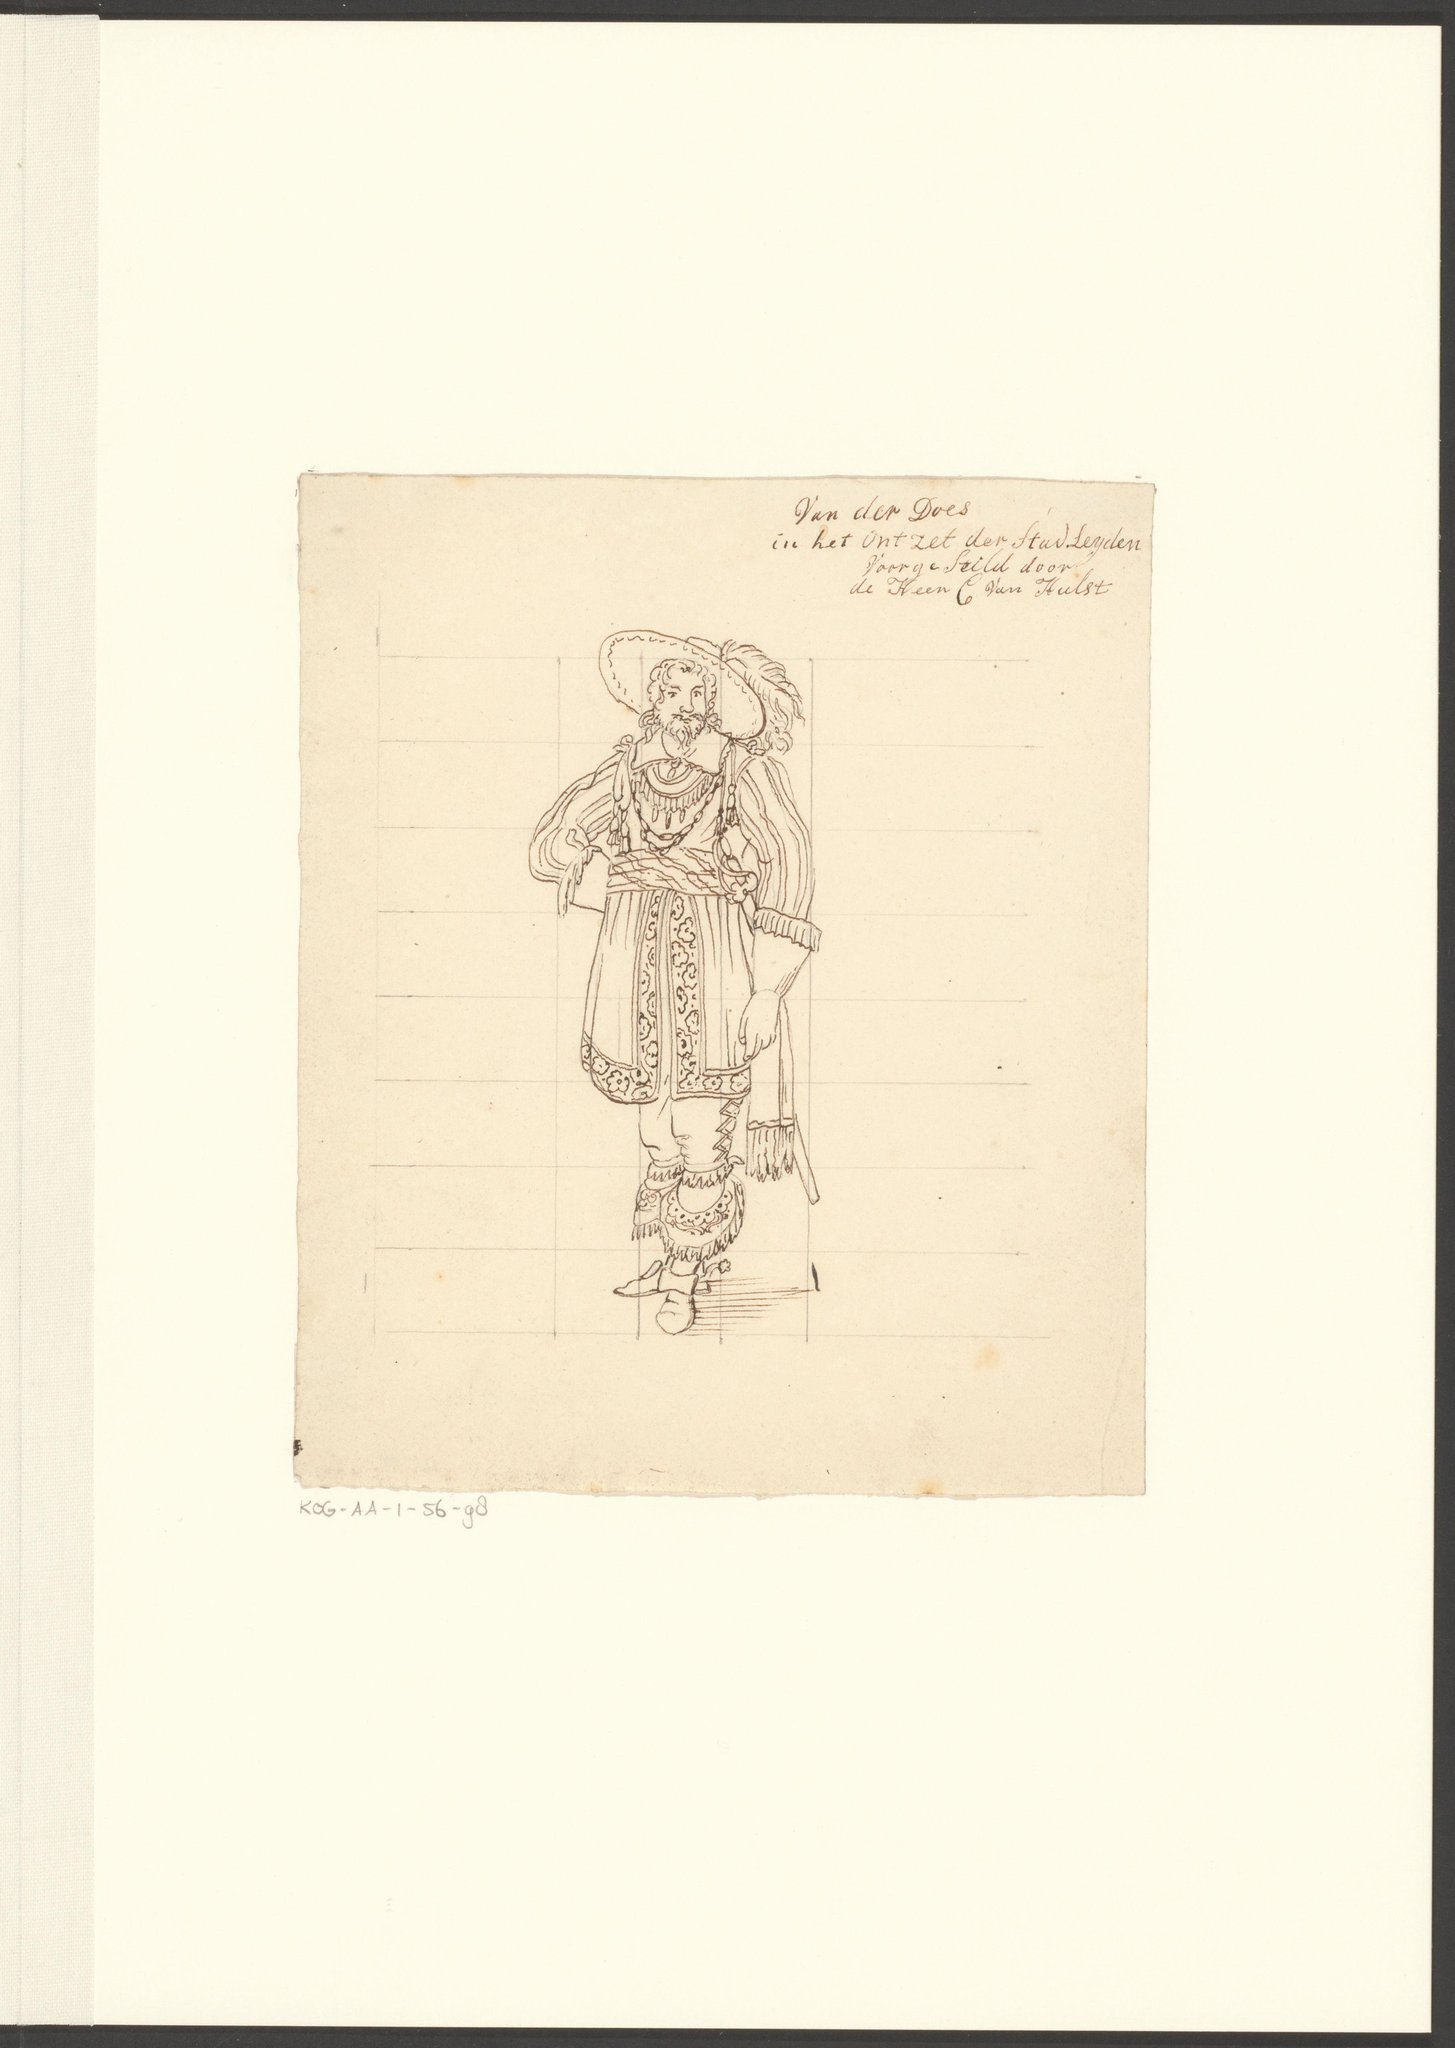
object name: drawing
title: Portret van toneelspeler Coenraad van Hulst in de rol van Van der Does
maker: johannes jelgerhuis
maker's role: draughtsman, painter, print maker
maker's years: 1770-1836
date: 1799-1836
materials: ink, paper, pencil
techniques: pen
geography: amsterdam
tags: bookseller, historical persons, portrait of actor, actress, actor (on the stage), amsterdam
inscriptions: inscription: ‘Van der Does / in het Ontzet der Stad Leyden / Voorgesteld door / de Heer C van Hulst’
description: Voorbereidende tekening op de prentserie Acteurs en actrices in verschillende rollen van Johannes Jelgerhuis.